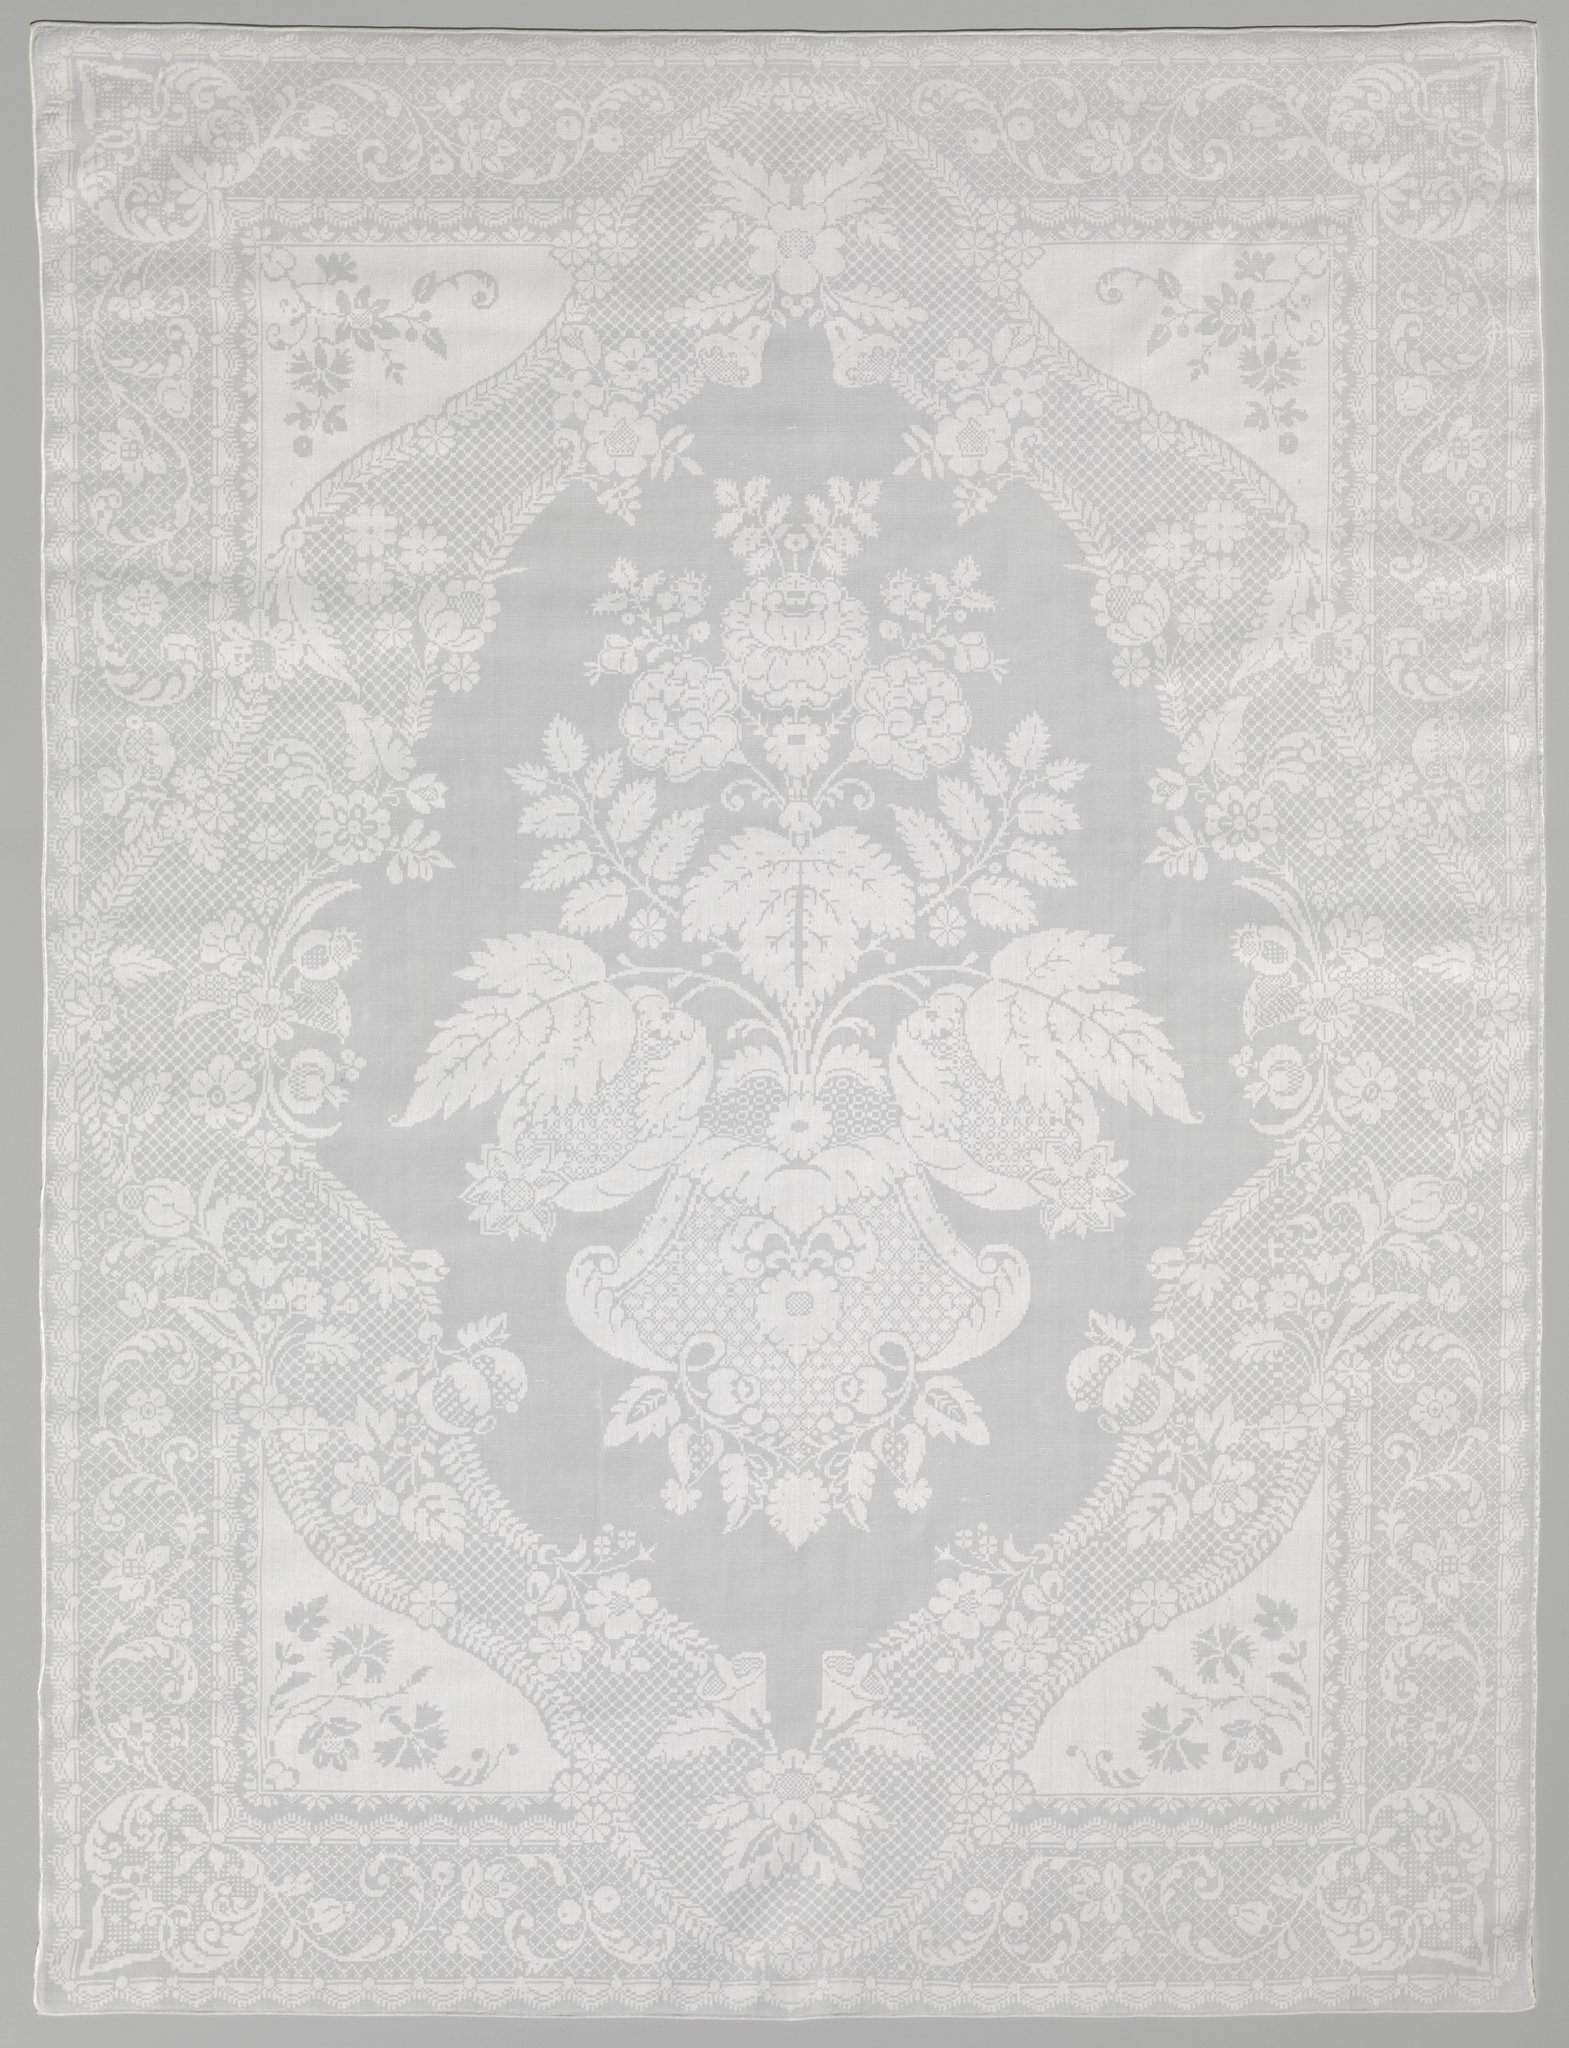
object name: napkin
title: Servet van linnendamast met een kantpatroon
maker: Anonymous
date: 1650-1700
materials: linen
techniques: damask, weave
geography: flanders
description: Servet van linnendamast met een kantpatroon. Bij het servet hoort een servet (BK-1977-295-A) en een tafellaken (BK-1977-294).